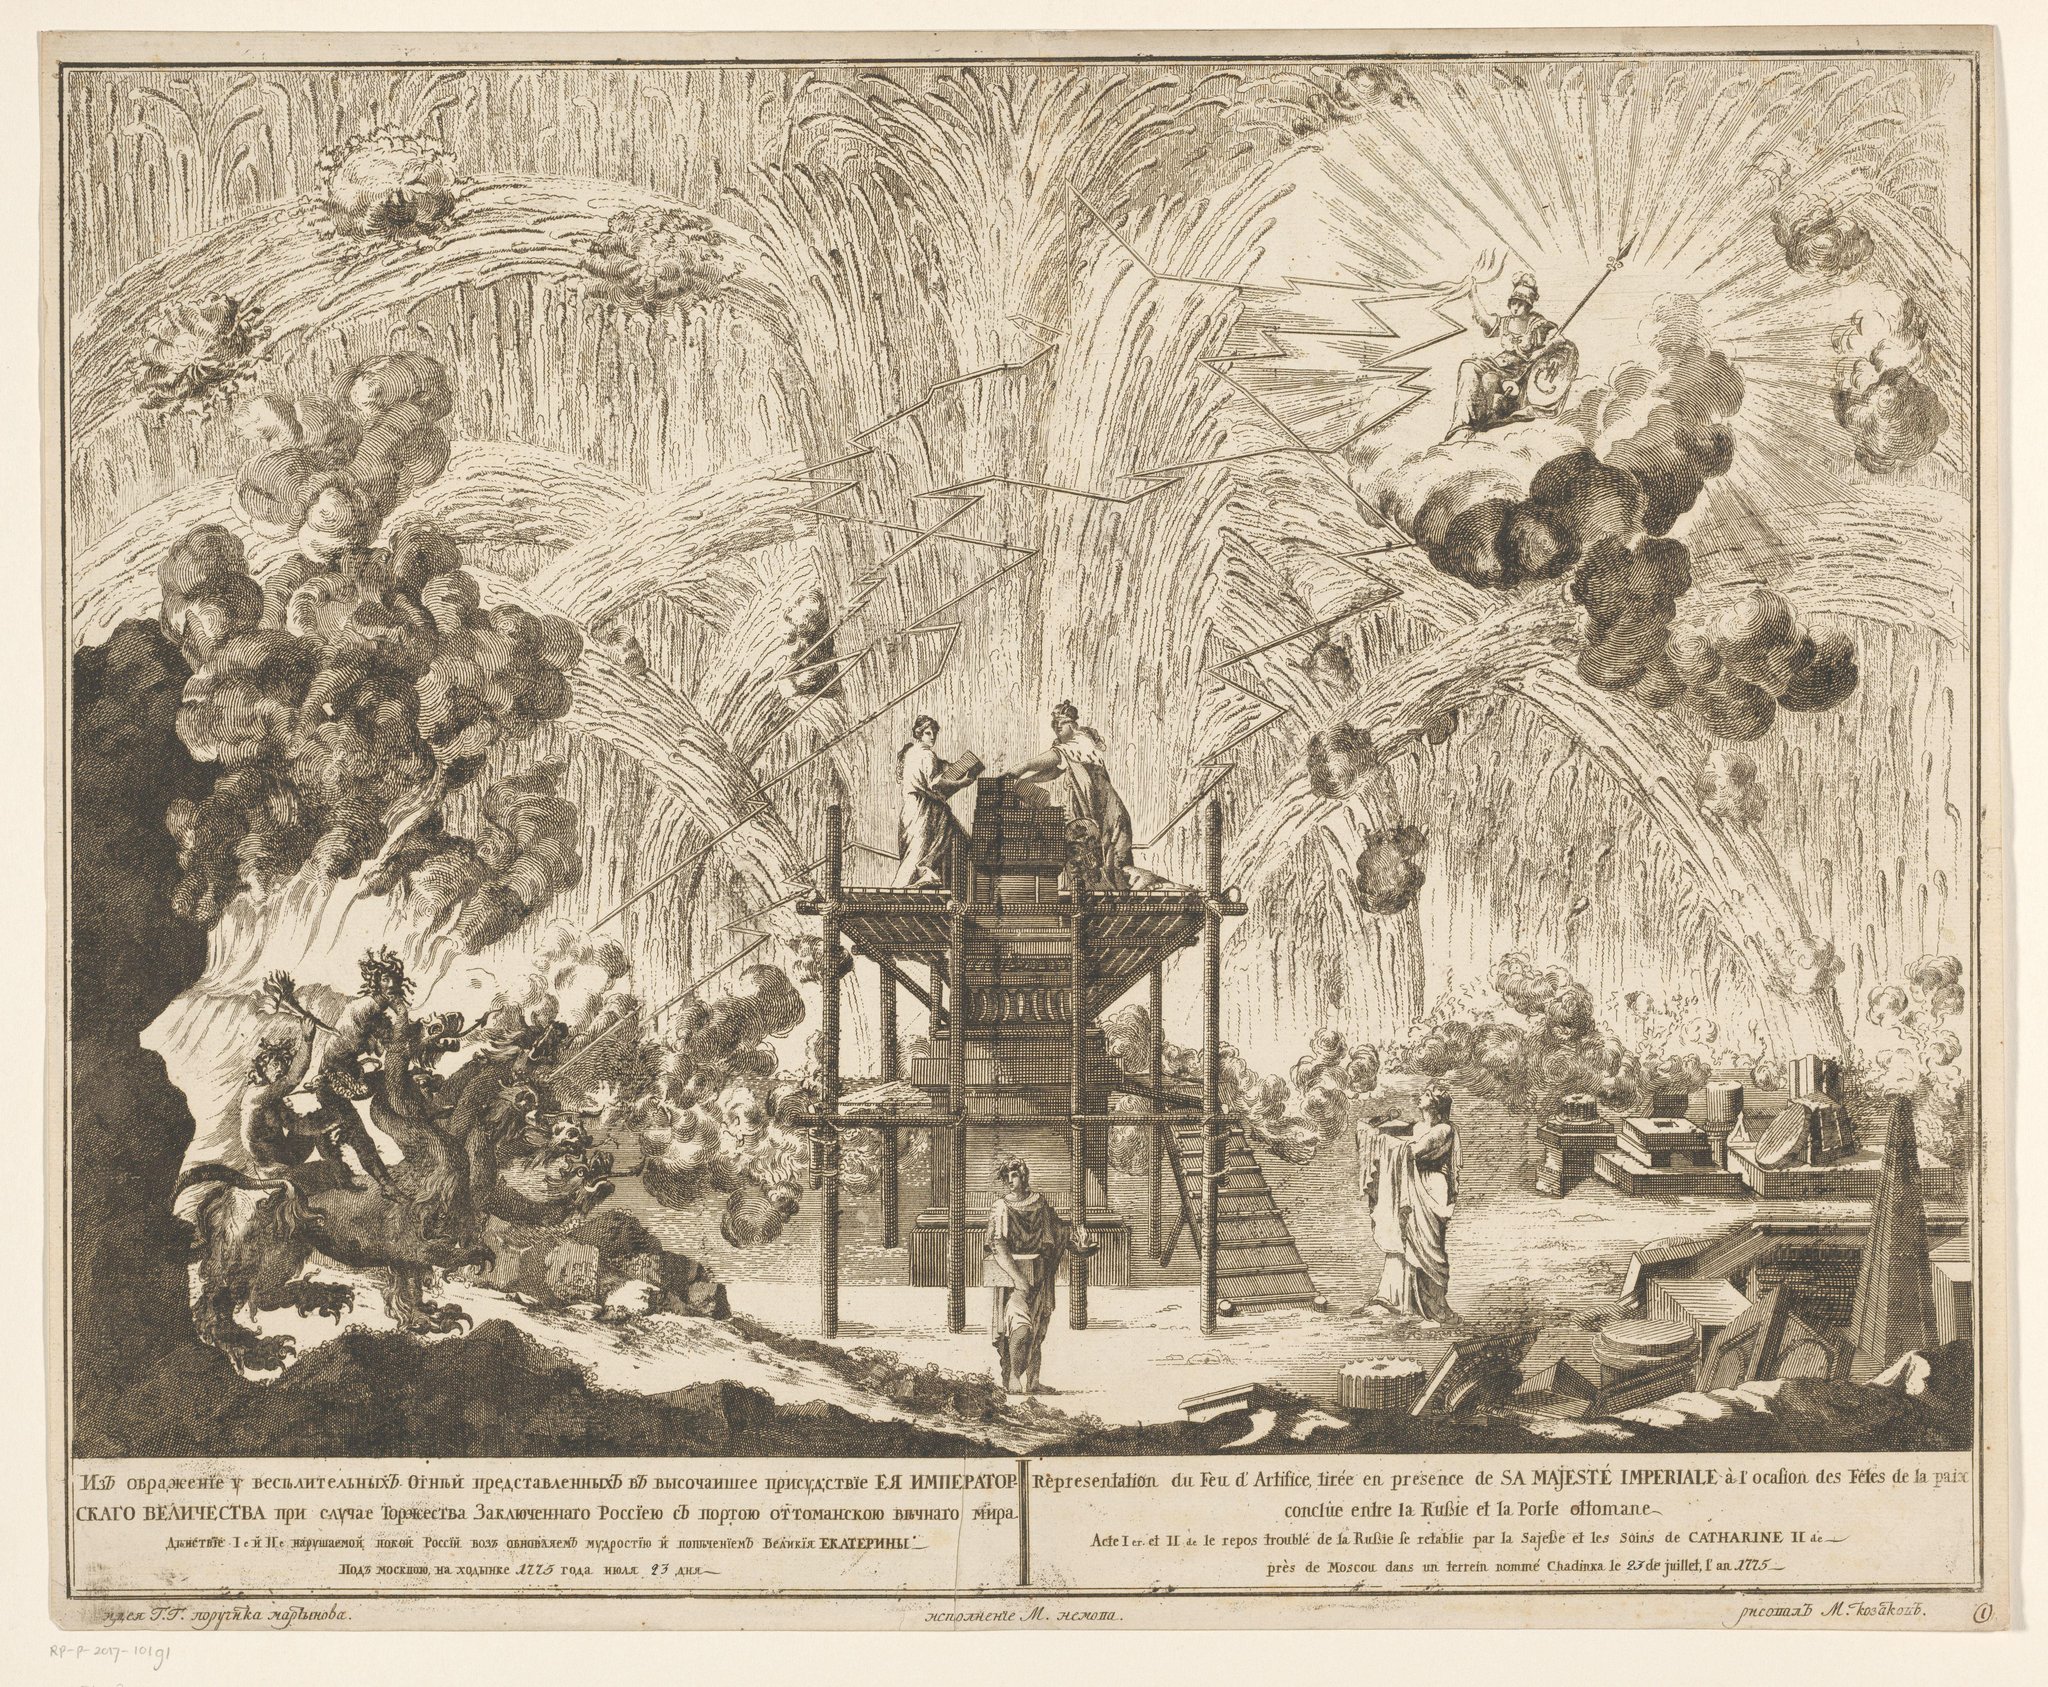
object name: print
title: Vuurwerk in Moskou bij de viering van het einde van de Russisch-Turkse Oorlog, 1775 (Acte I en II)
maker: emelian alekseevič fedoseev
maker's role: print maker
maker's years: 1745-1778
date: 1775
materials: paper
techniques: etching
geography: moscow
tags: catharina de grote, bonfire, fire-works, festivities on events of national importance (+ illumination, fire-works ~ festive activities)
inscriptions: collector's mark: Lugt 2228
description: Vuurwerk in Moskou bij de viering op 23 juli 1775 van het einde van de Russisch-Turkse Oorlog met het sluiten van Verdrag van Küçük Kaynarca. Vuurwerk afgestoken in aanwezigheid van tsarina Catharina de Grote. Onderdeel van een serie van drie platen met onderschriften in het Russisch en Frans.